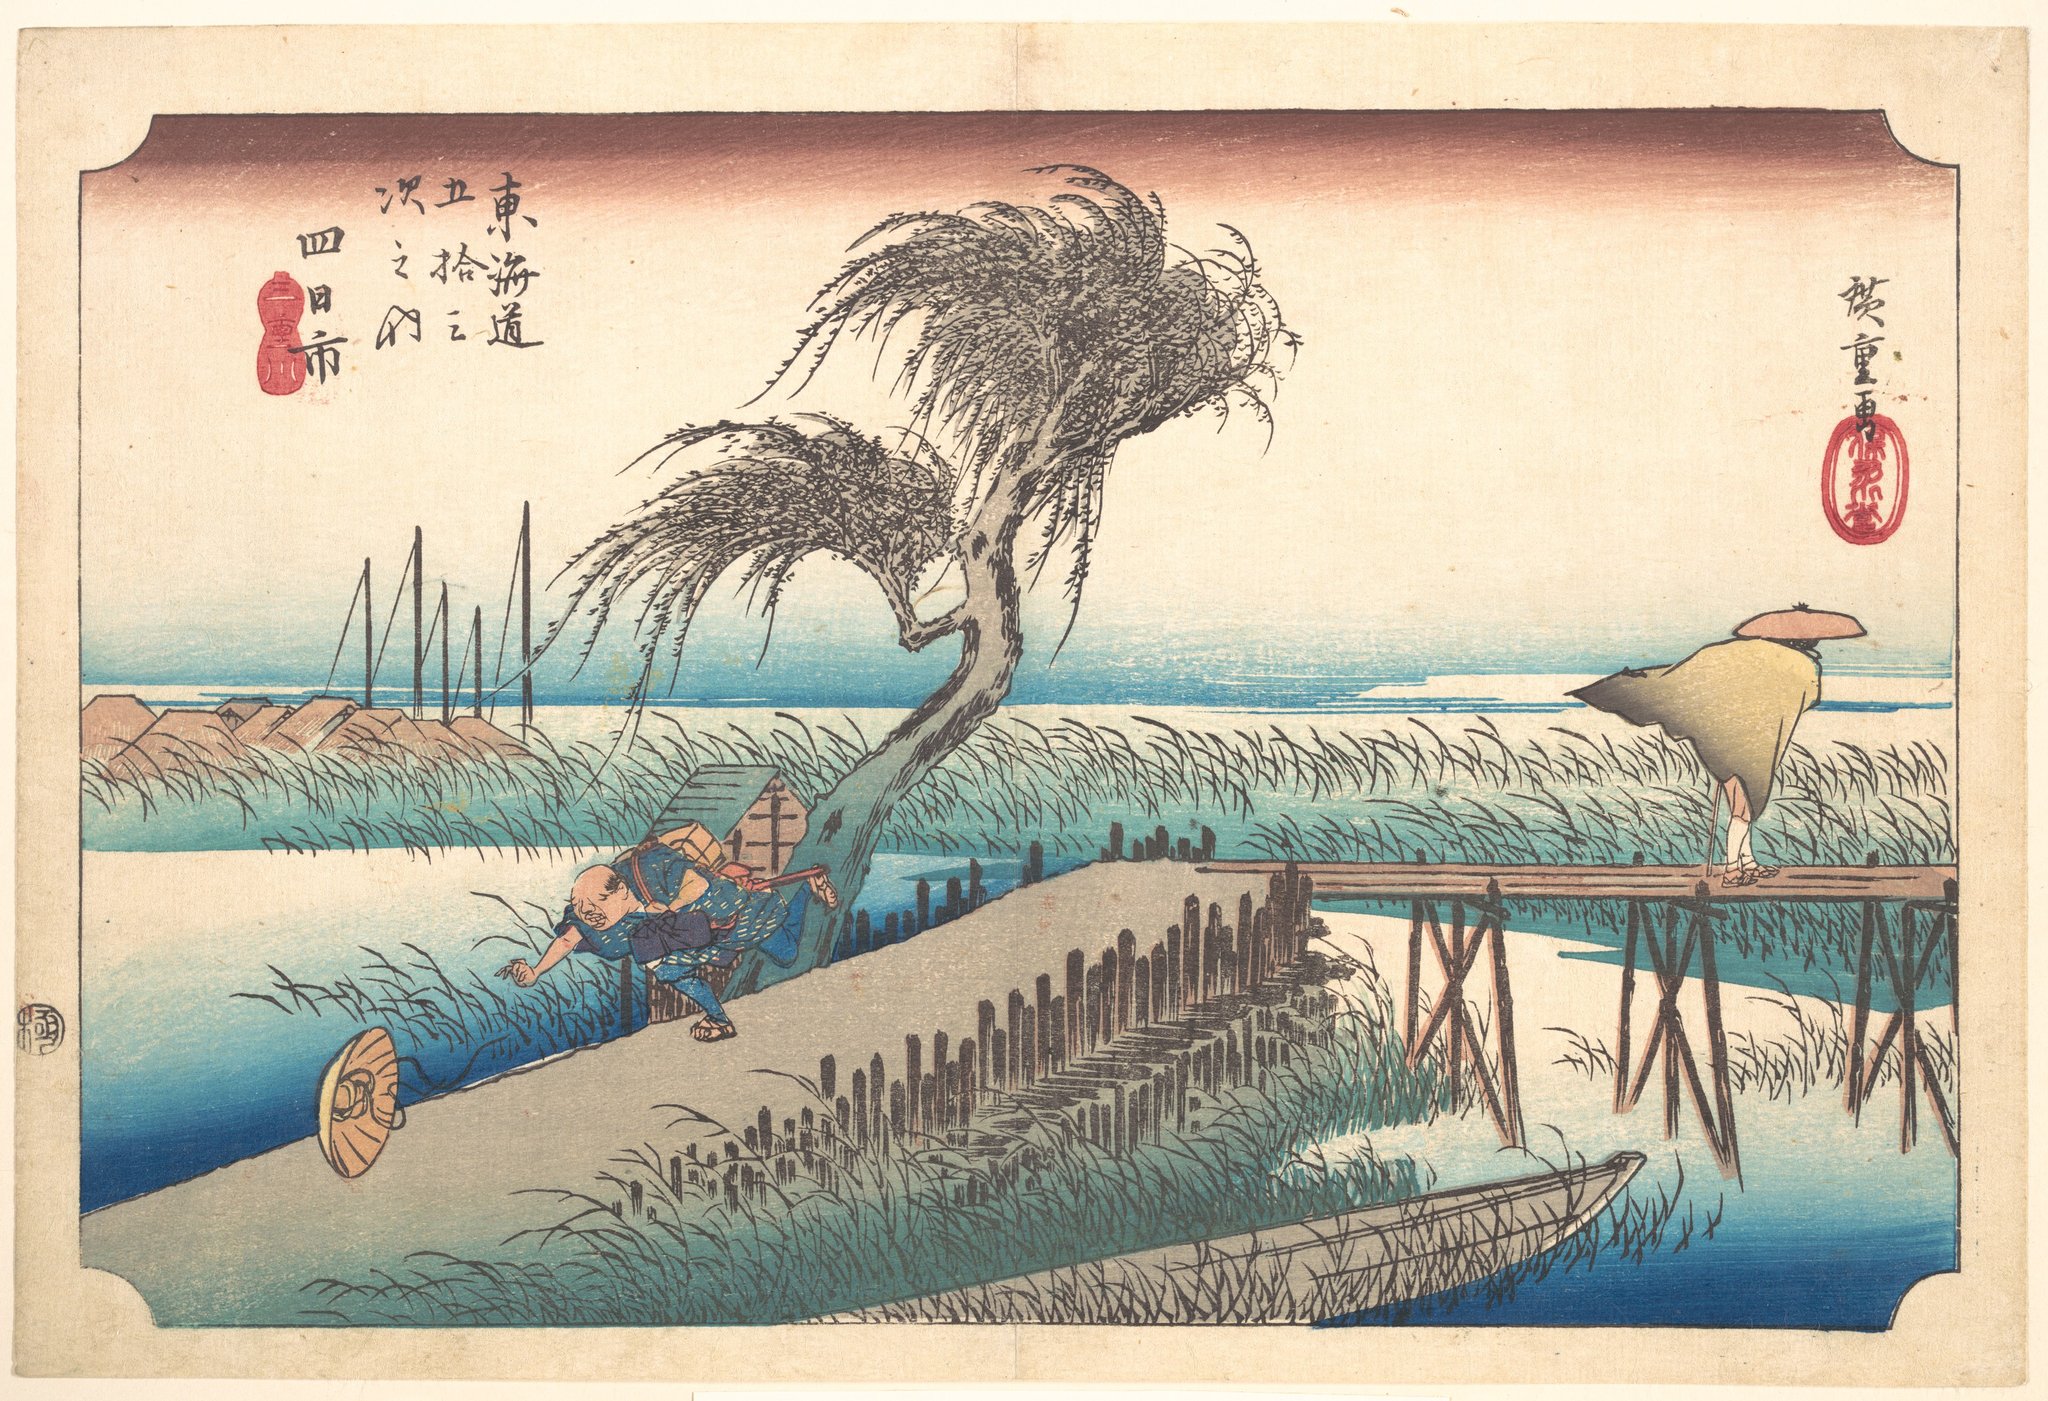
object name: print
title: Mie River at Yokkaichi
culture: japanese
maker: utagawa hiroshige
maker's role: artist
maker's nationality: japanese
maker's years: 1797-1858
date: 1834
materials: ink, paper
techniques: woodblock print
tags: bridges,men,trees,wind